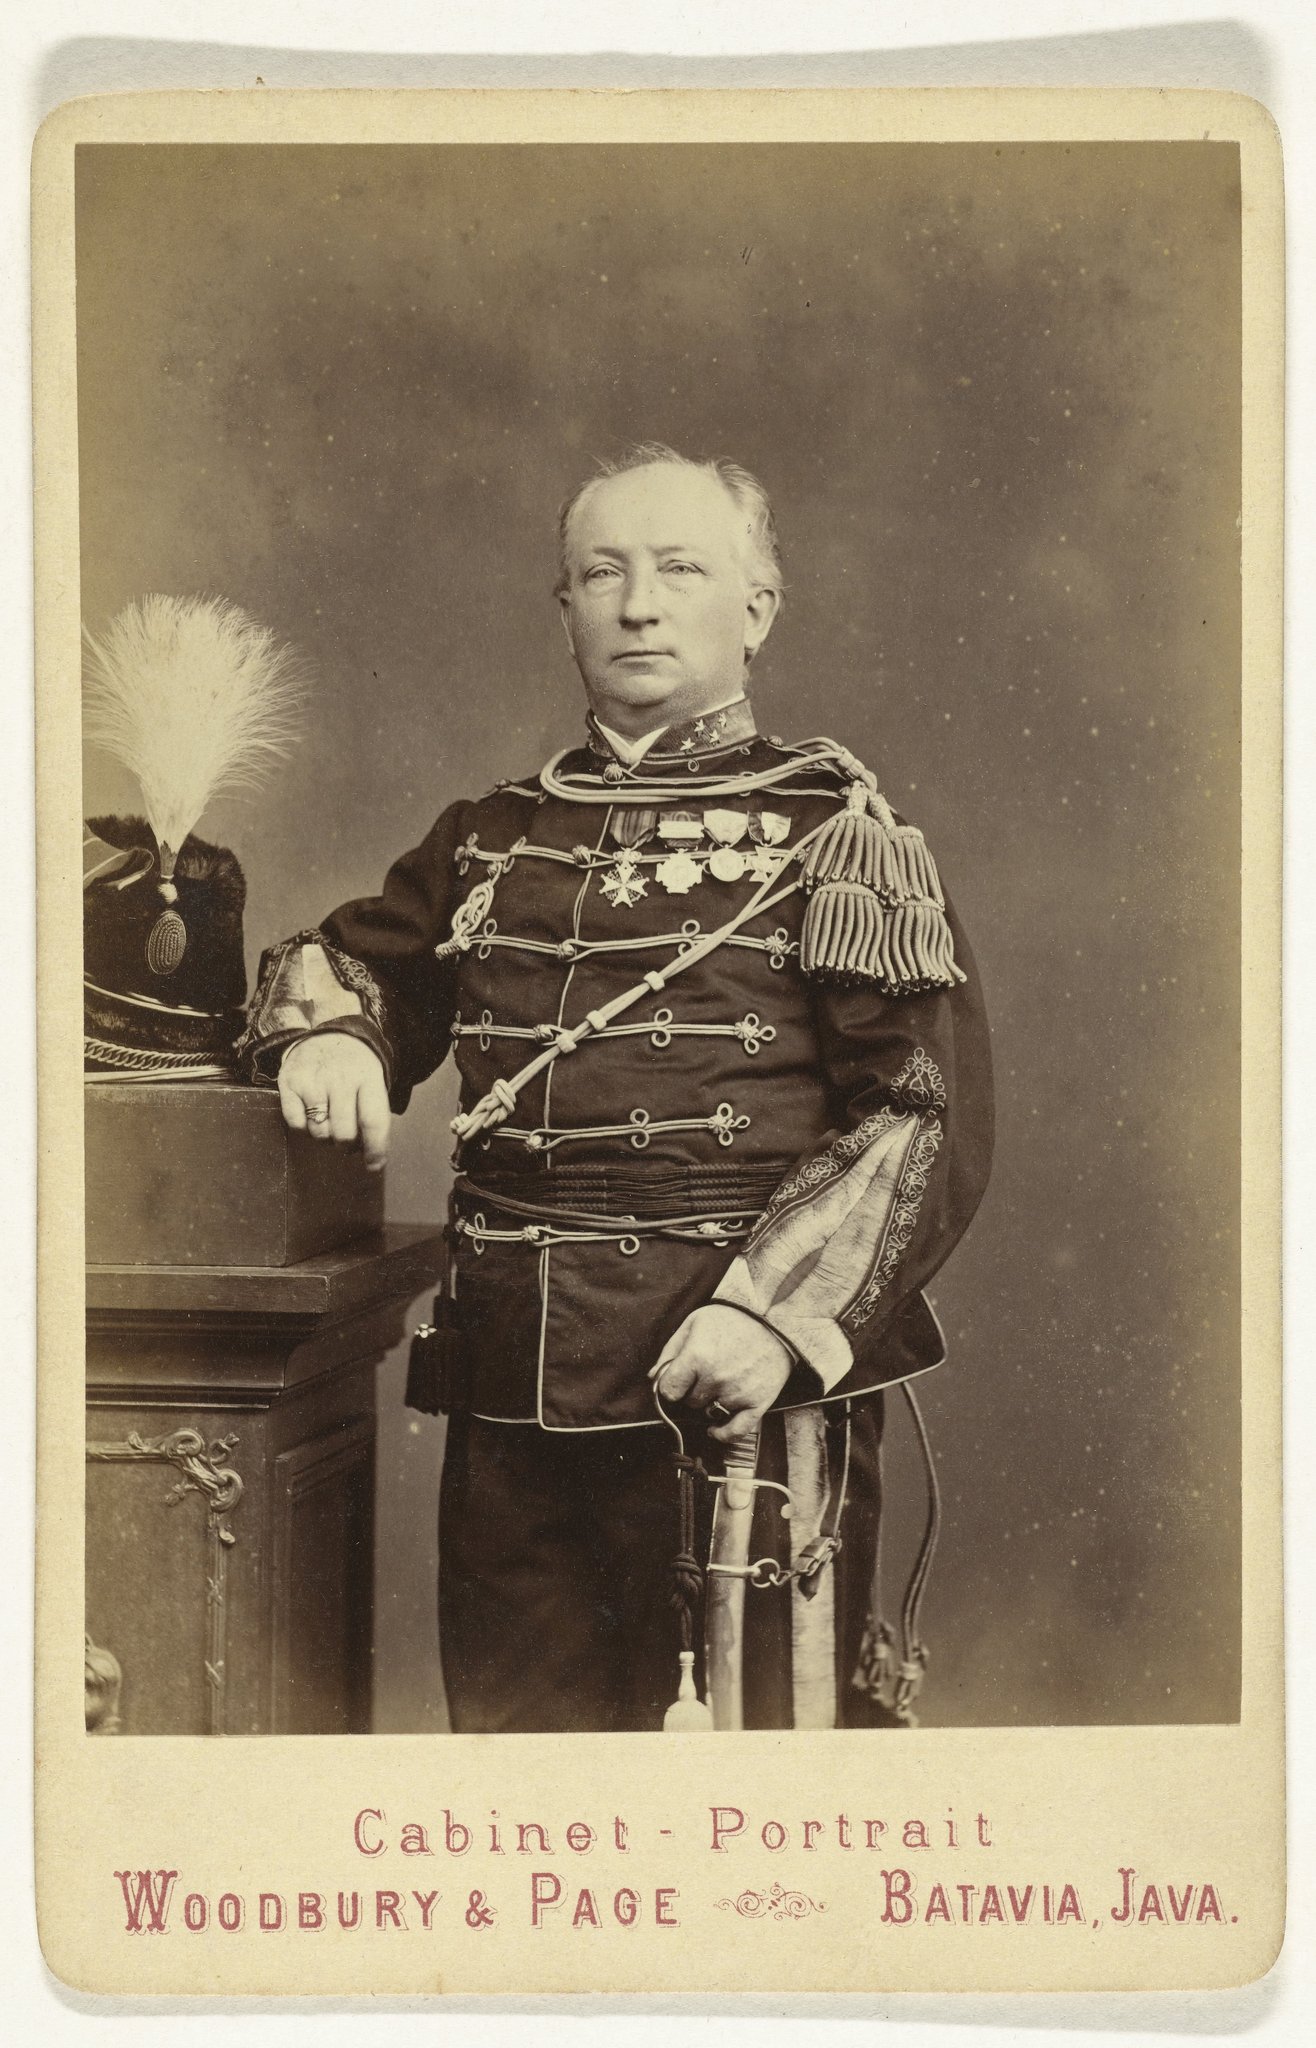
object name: photograph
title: Studioportret van Generaal-Majoor G.B.T. Wiggers van Kerchem met onder andere zijn Militaire Willemsorde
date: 1875-1895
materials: paper, photographic support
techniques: photography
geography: batavia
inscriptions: inscription: ‘H. de Lange’, name: ‘Cabinet Portrait Woordbury & Page Batavia Java’